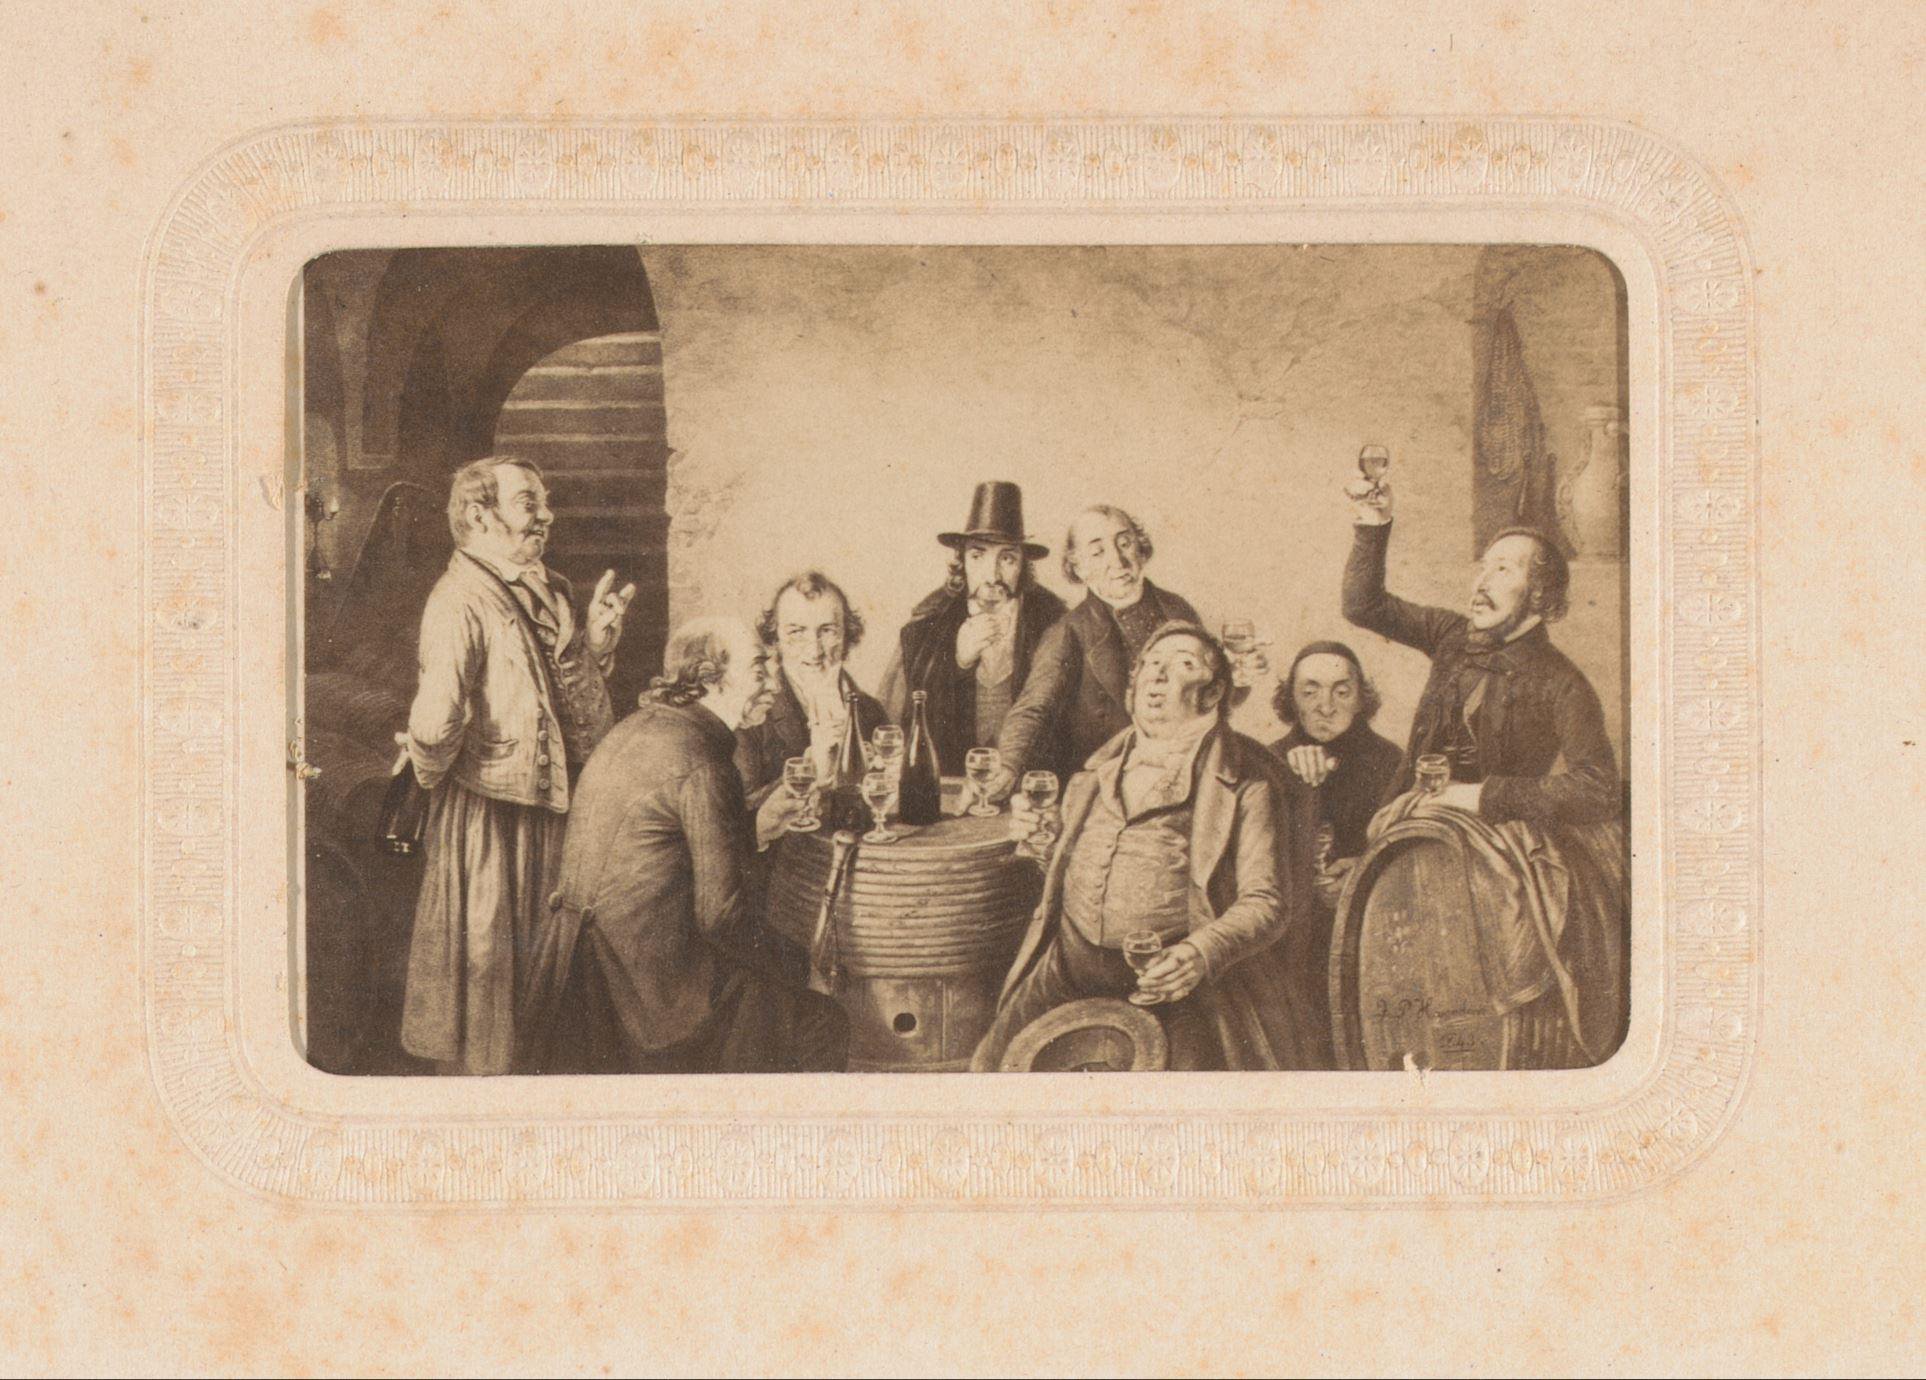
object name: reproduction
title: Fotoreproductie van een schilderij met een drinkend gezelschap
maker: Anonymous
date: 1855-1865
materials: cardboard, photographic support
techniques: albumen print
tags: drinking